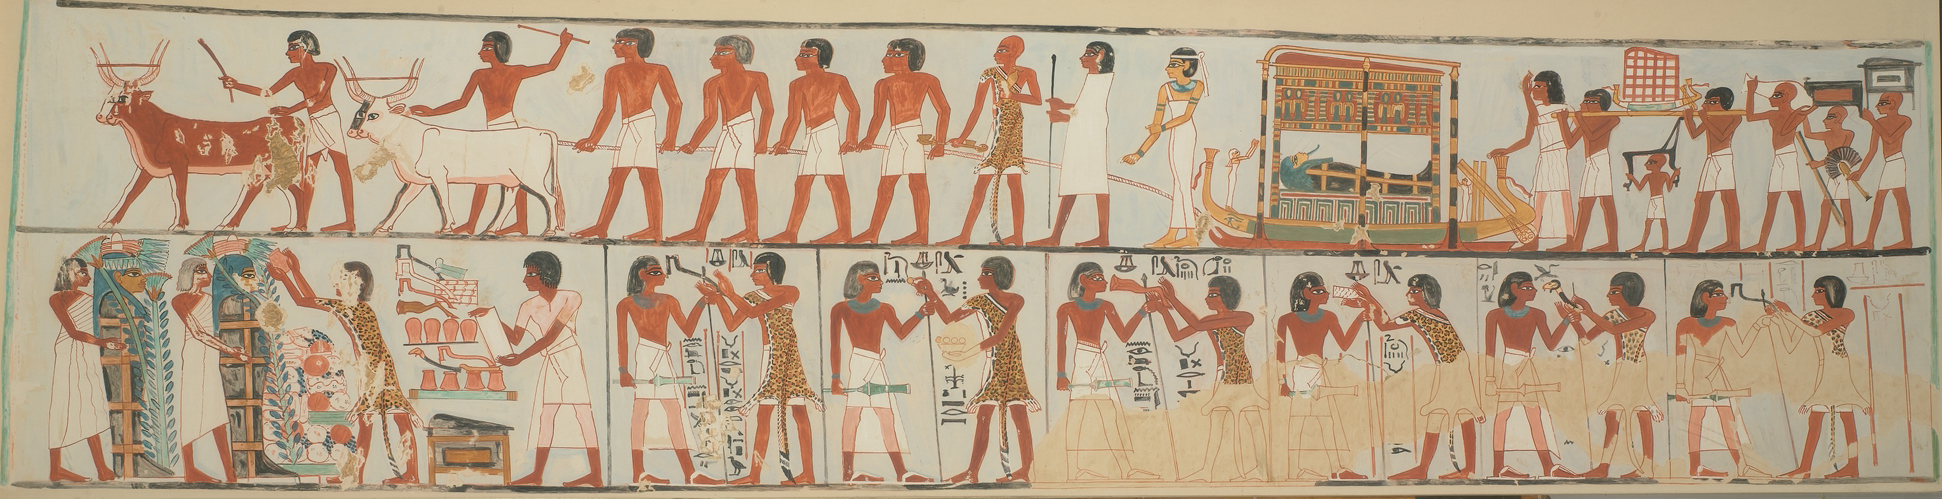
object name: facsimile, pairy tt 139, funeral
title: Funeral Procession, Tomb of Pairy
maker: nina de garis davies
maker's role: artist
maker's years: 1881-1965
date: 1390-1352 BCE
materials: paper, paint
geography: egypt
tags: men,women,coffins,funerals,processions